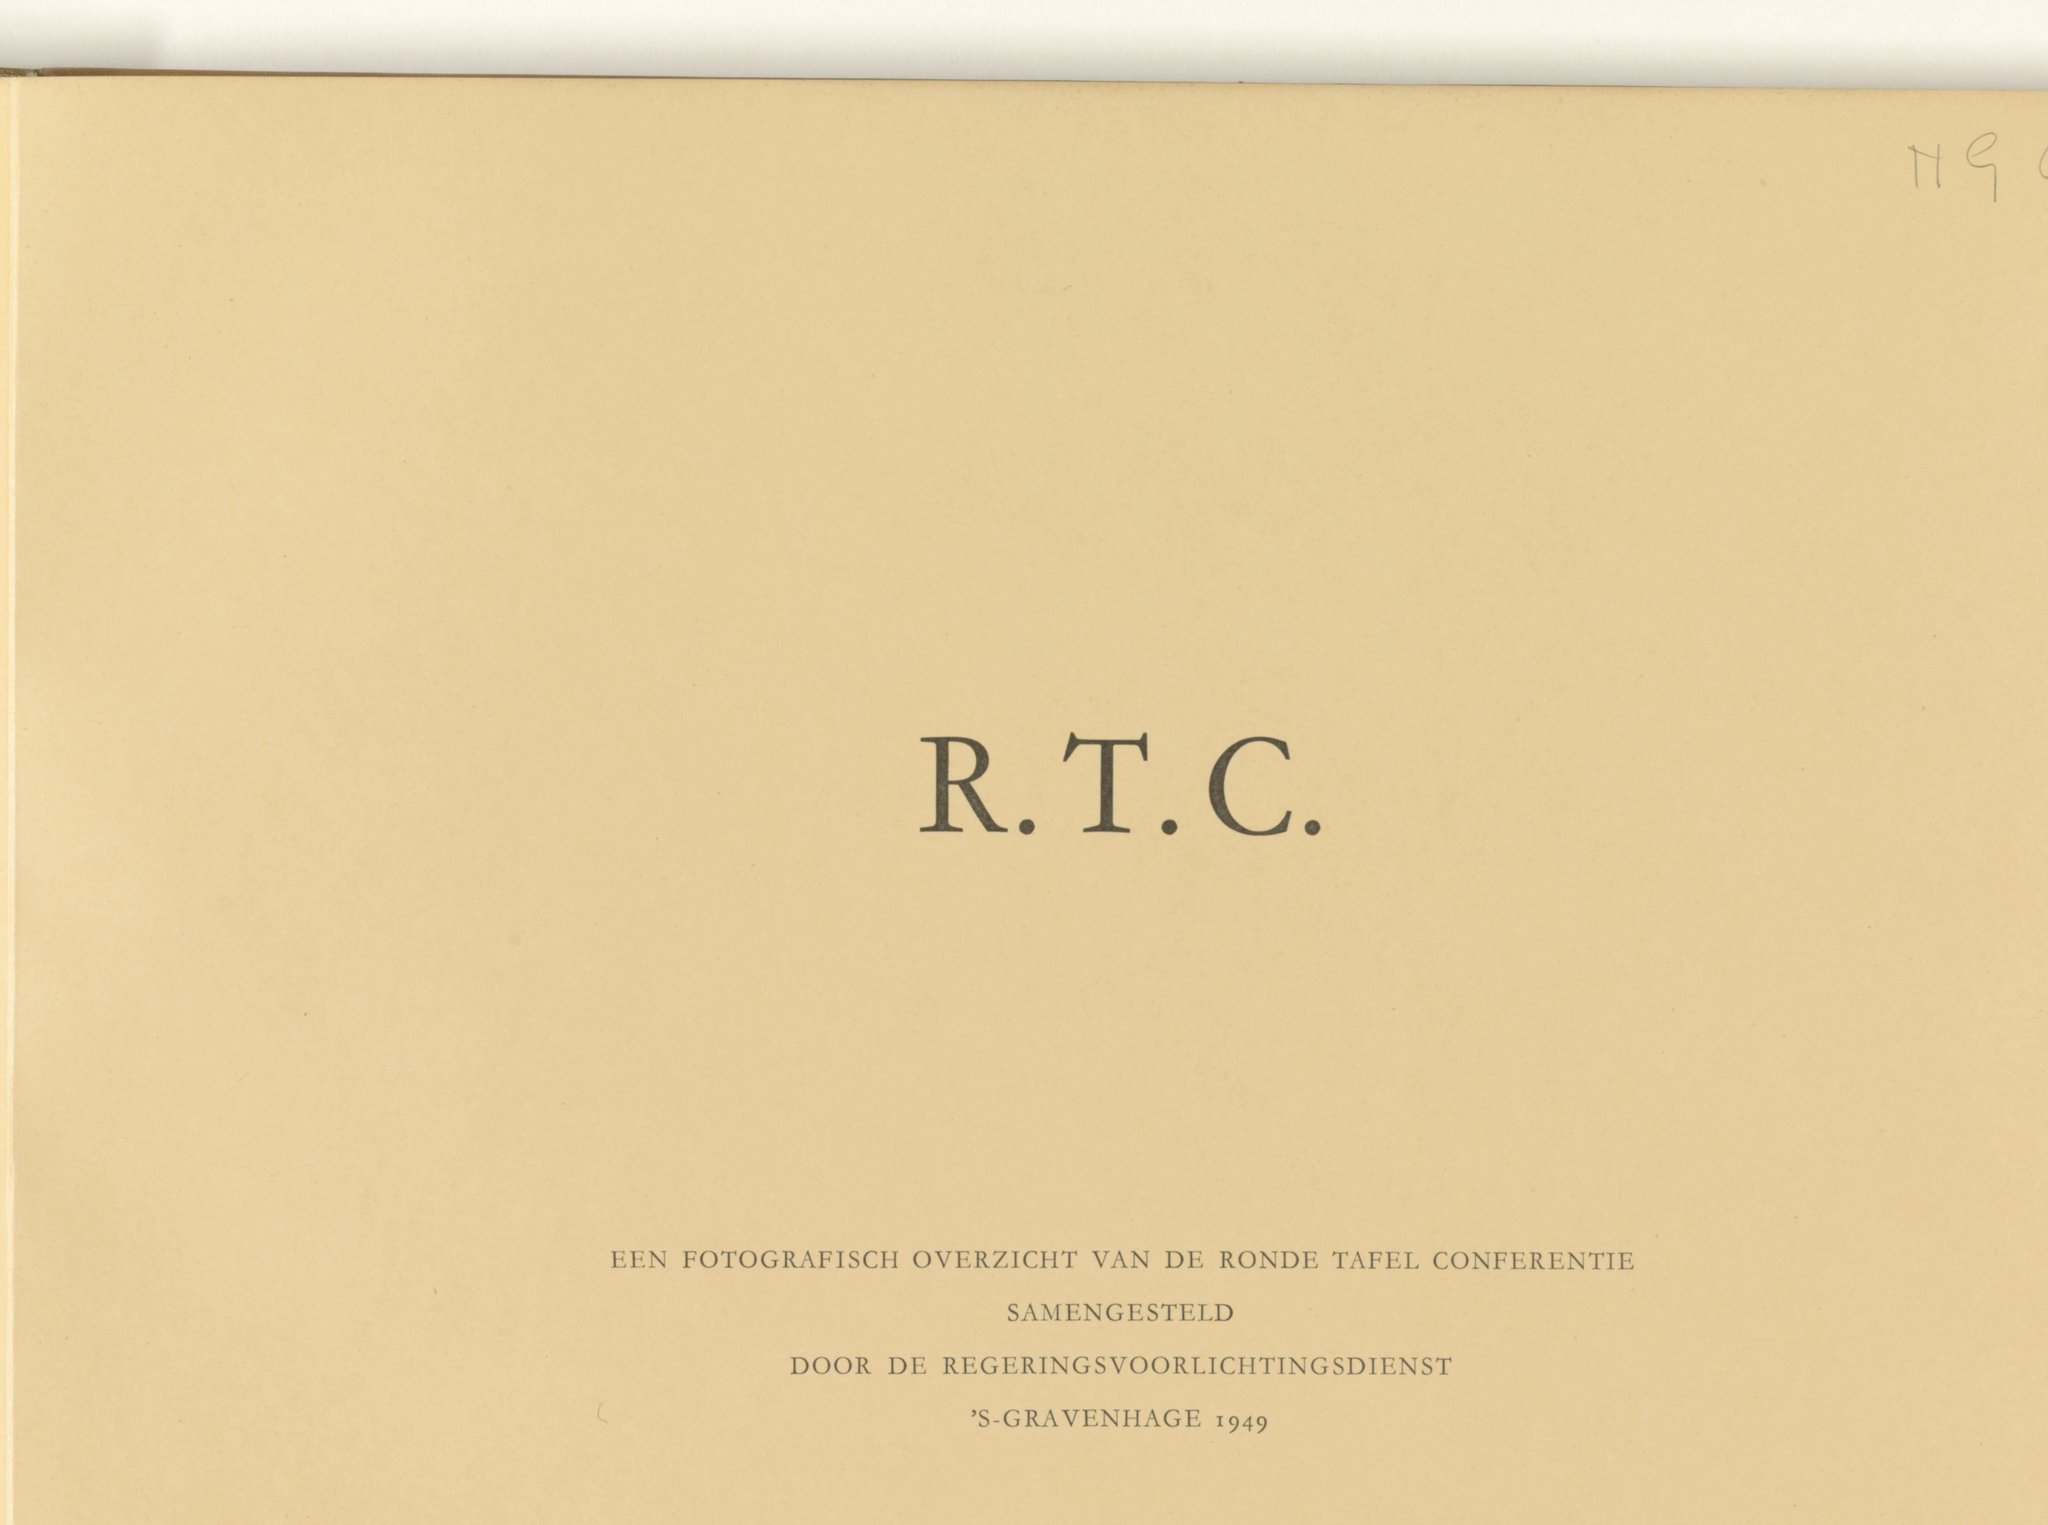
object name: titelblad, titelpagina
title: R.T.C. Een fotografisch overzicht van de Ronde Tafel Conferentie samengesteld door de Regeringsvoorlichtingsdienst 's-Gravenhage 1949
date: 1949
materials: paper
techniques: printing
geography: the hague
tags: willem drees, netherlands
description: Titelblad voor het fotoalbum met 37 foto's van de rondetafelconferentie gehouden tussen 23 augustus en 2 november in Den Haag in 1949 tussen vertegenwoordigers van Nederland, de Republiek Indonesië en de Bijeenkomst Federaal Overleg. Het exemplaar aangeboden aan premier Willem Drees.